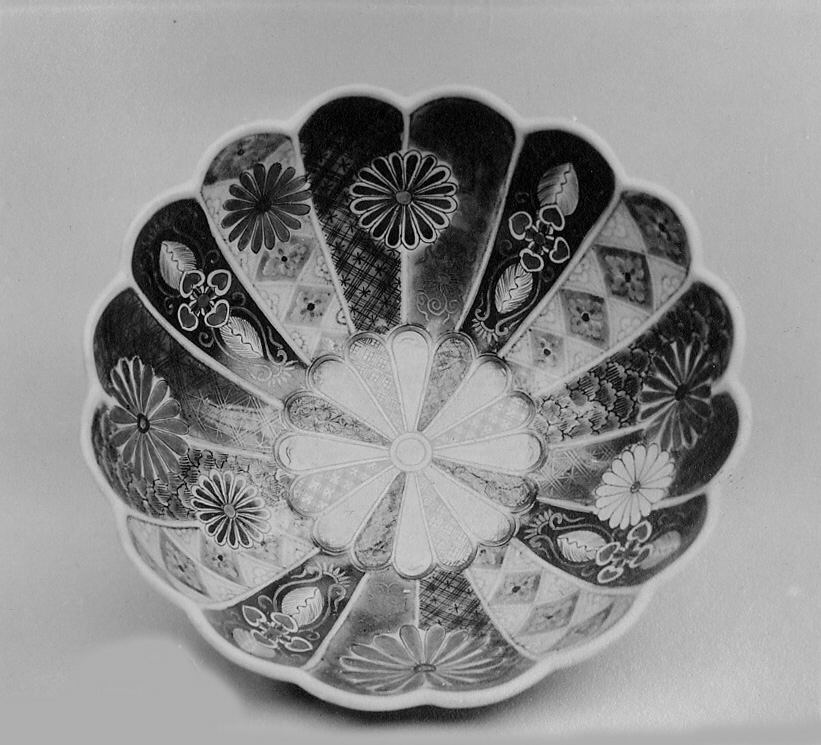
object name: bowl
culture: japanese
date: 1800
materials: enamel, porcelain